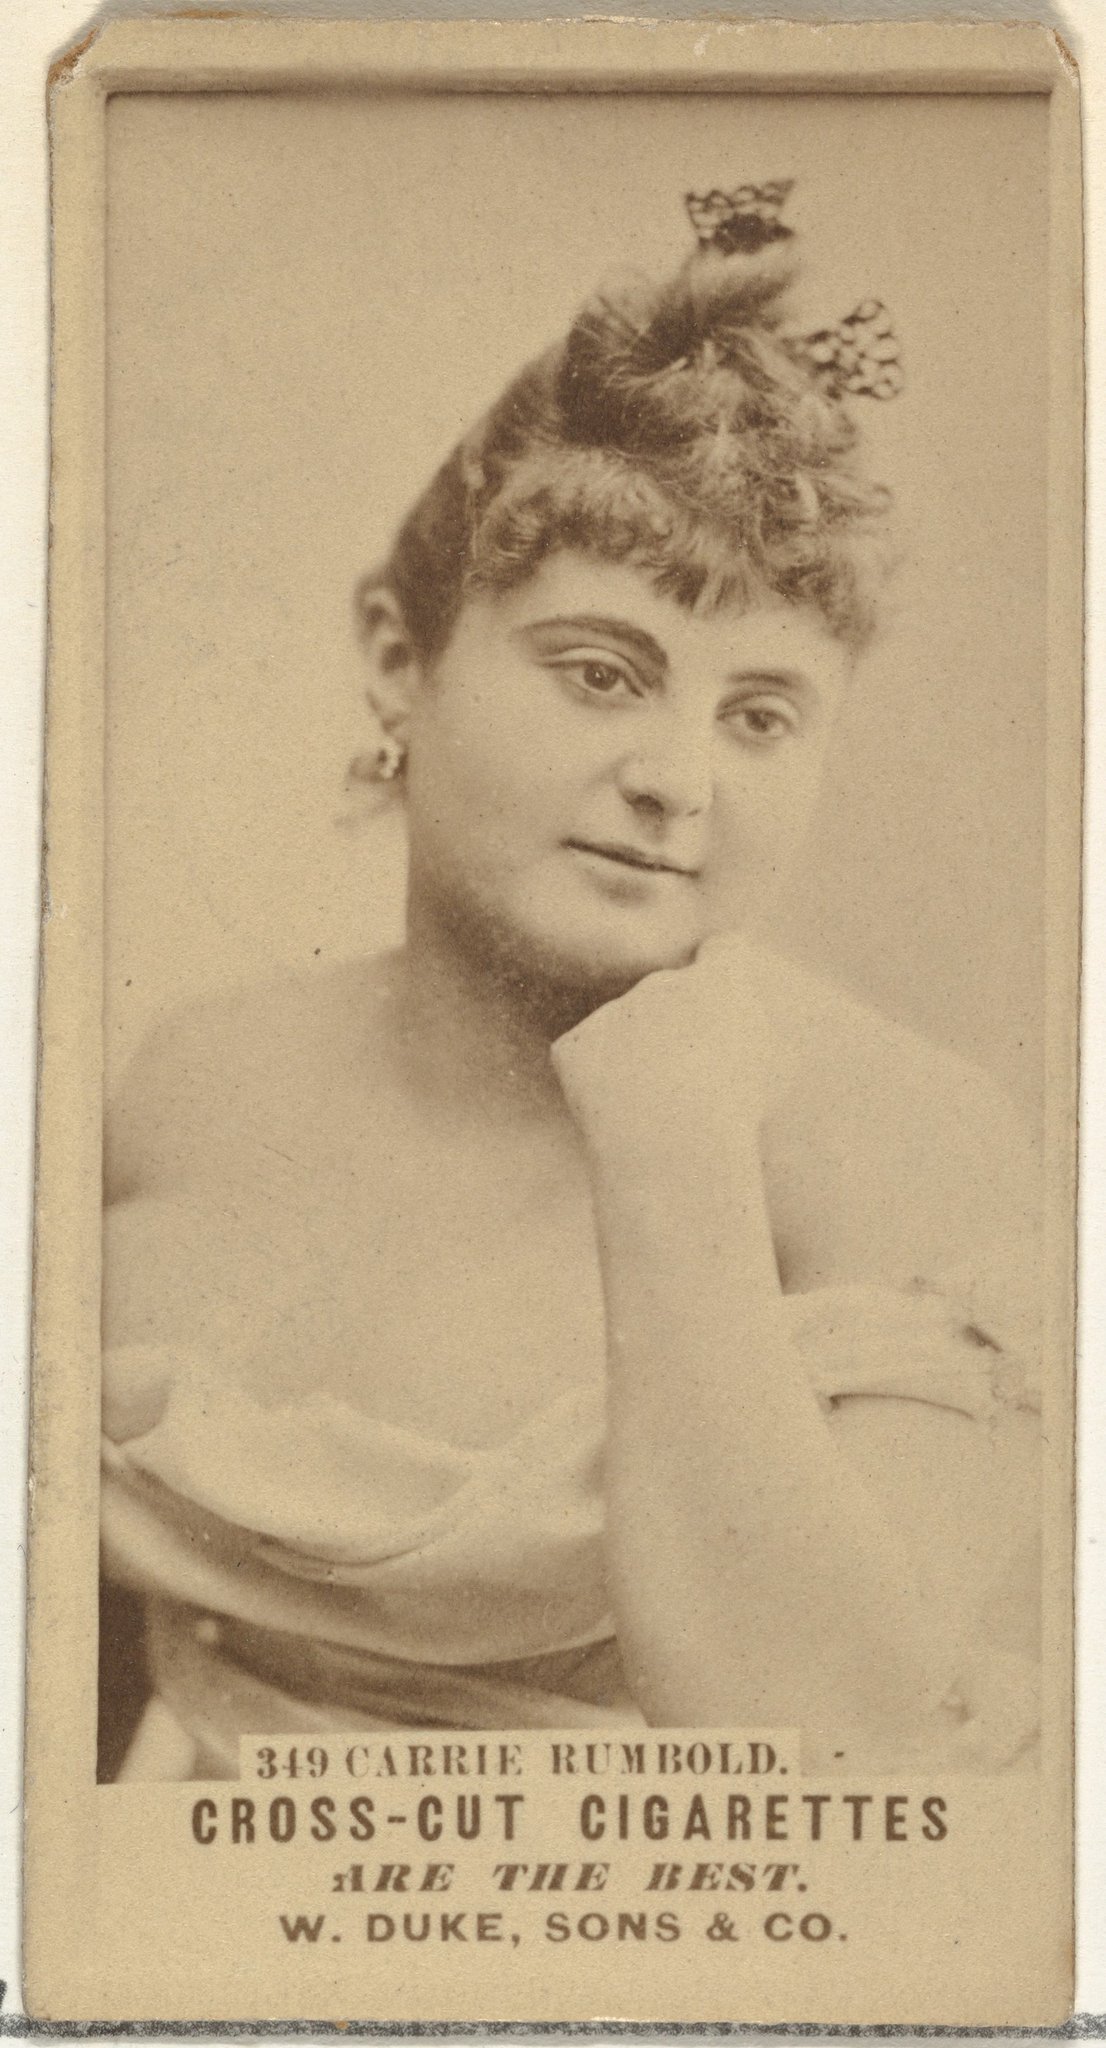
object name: photograph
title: Card Number 349, Carrie Rumbold, from the Actors and Actresses series (N145-3) issued by Duke Sons & Co. to promote Cross Cut Cigarettes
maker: w. duke, sons & co.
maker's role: publisher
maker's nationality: american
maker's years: 1870-1920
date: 1880-1889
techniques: albumen silver print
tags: portraits,women,actresses